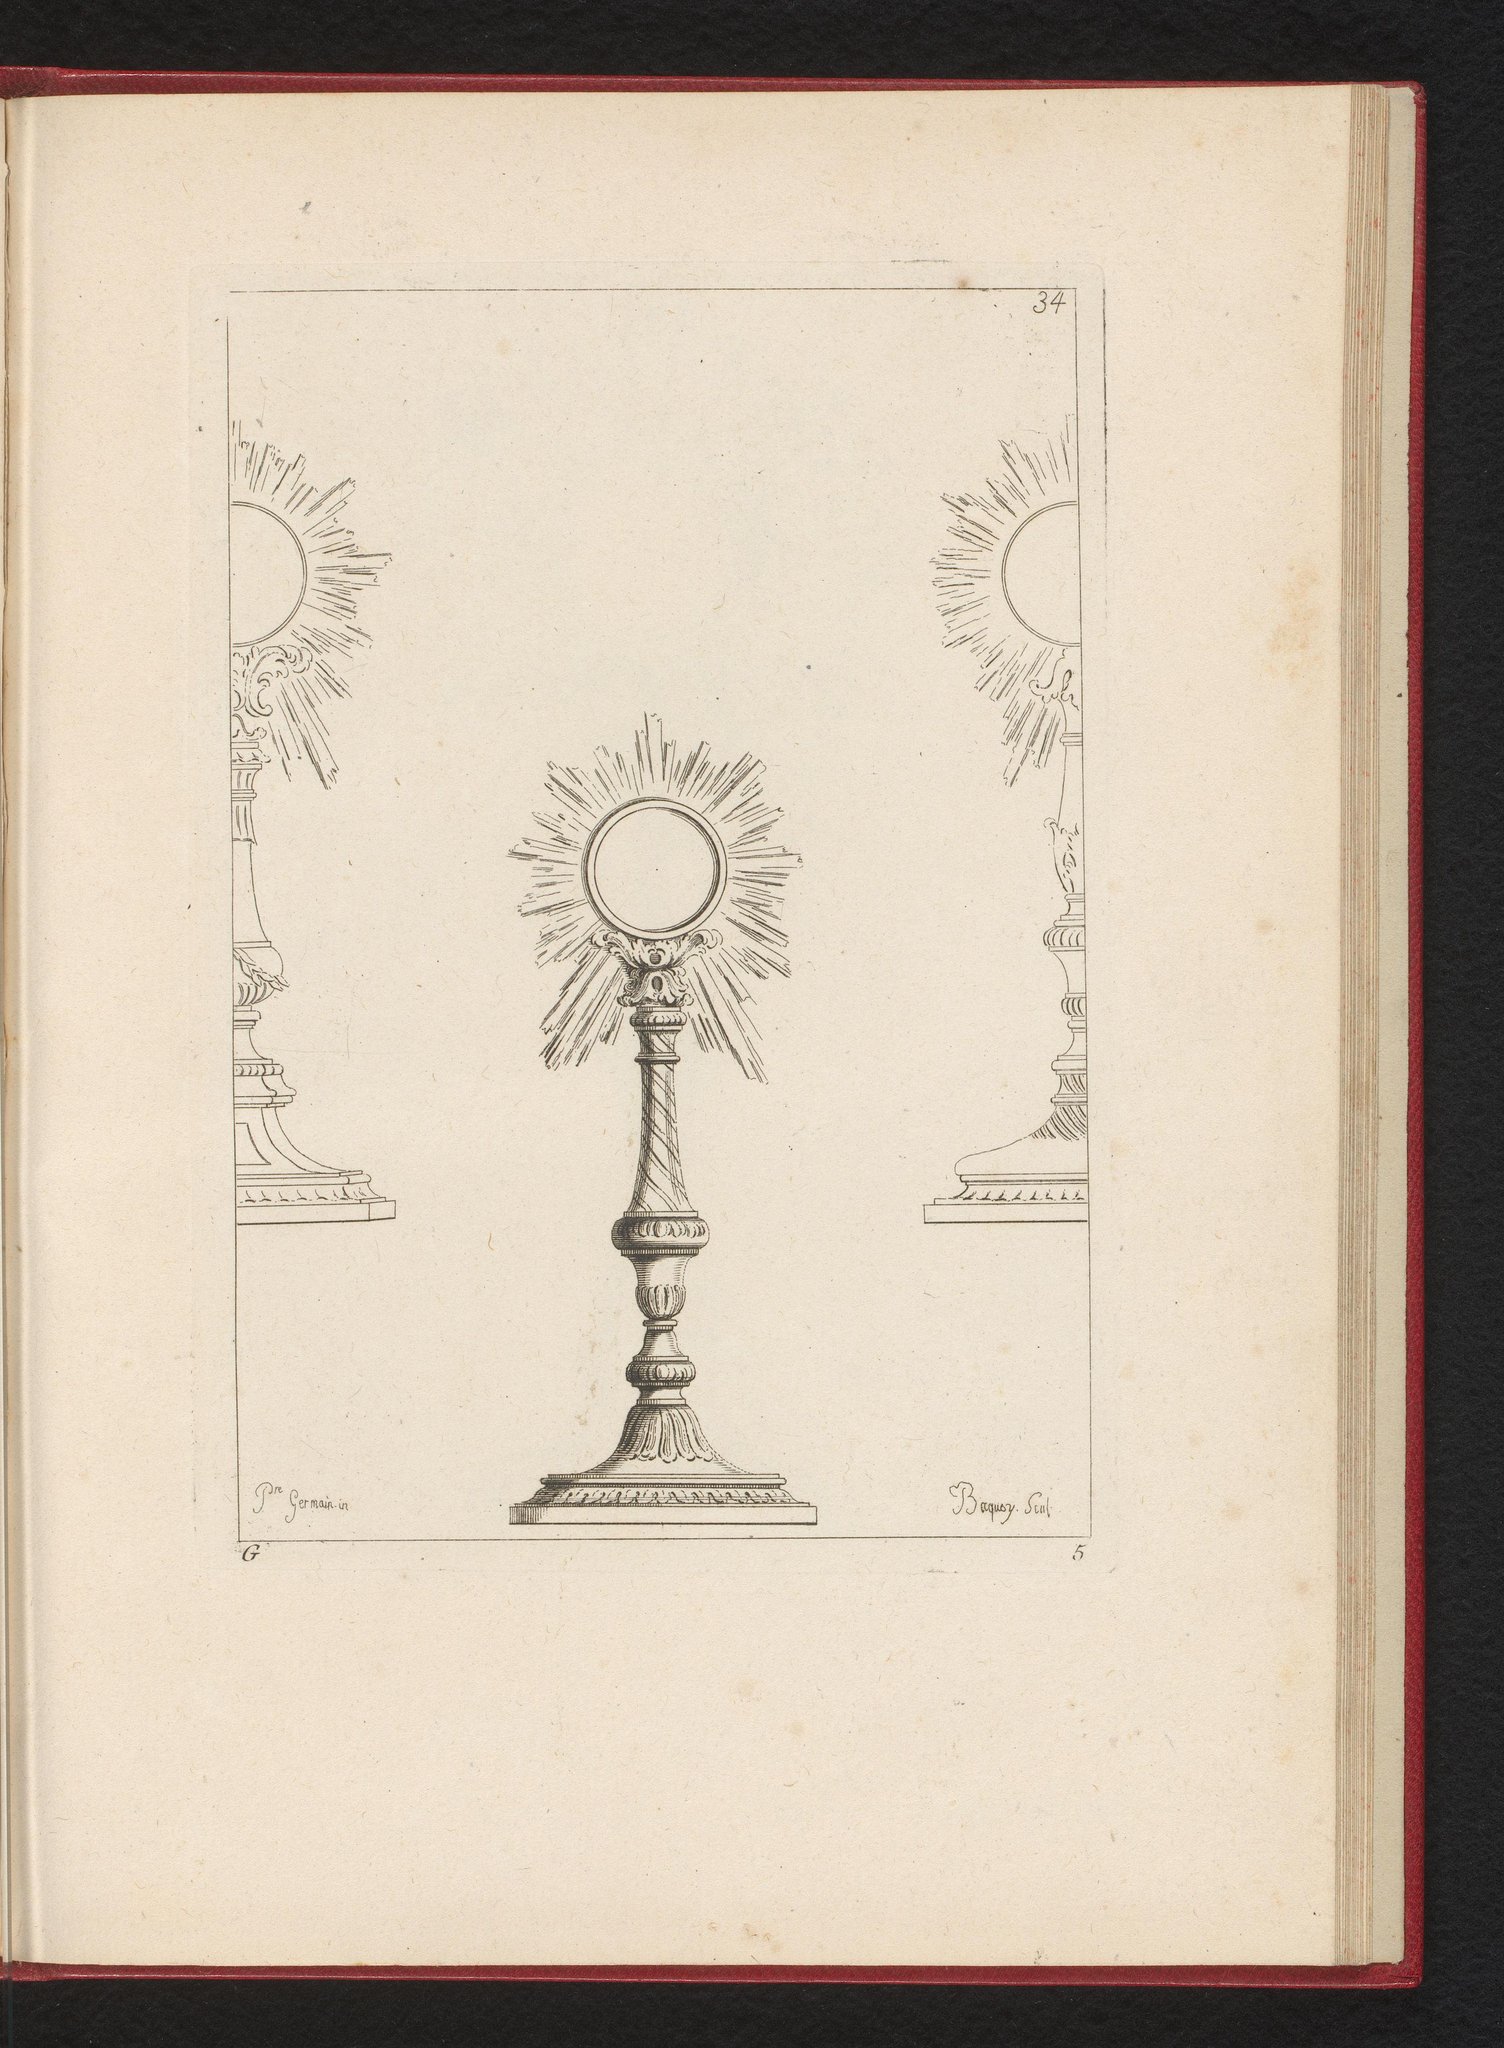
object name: album leaf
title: Zilverwerk en edelsmeedkunst, eerste deel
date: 1748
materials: paper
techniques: etching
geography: paris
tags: ostensorium, monstrance, jeweller, goldsmith, silversmith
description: Deze prent maakt deel uit van een album.